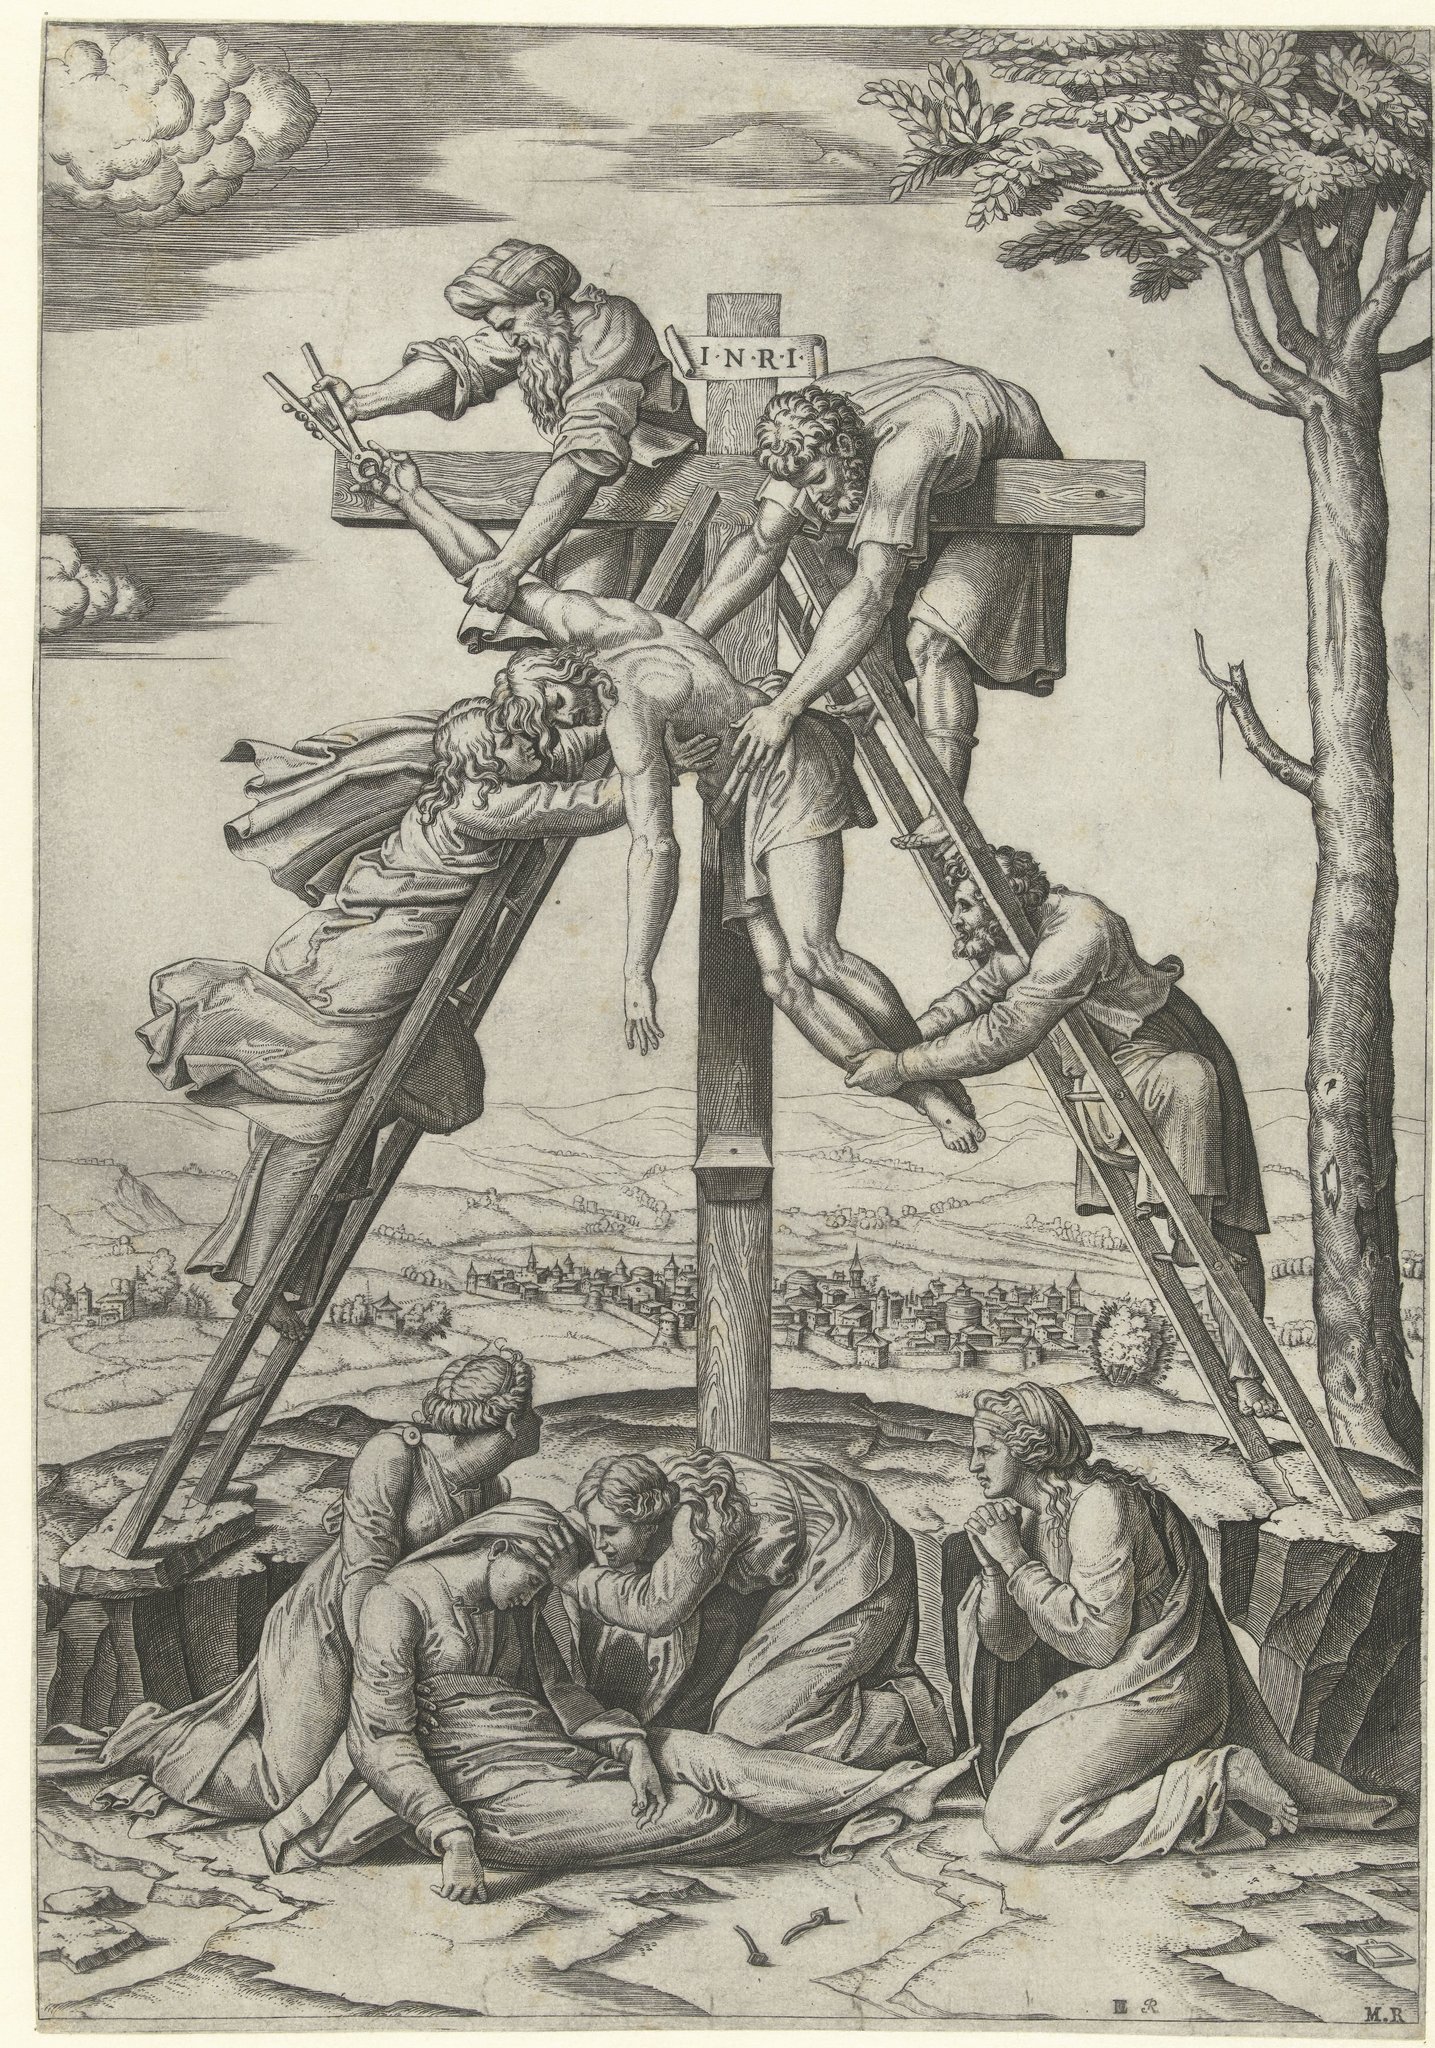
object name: print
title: Kruisafneming van Christus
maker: marcantonio raimondi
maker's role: print maker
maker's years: 1470-1534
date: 1520-1521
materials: paper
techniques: engraving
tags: descent from the cross: christ is taken down from the cross, usually by nicodemus and joseph of arimathaea who are standing on the ladders (both arms of christ detached)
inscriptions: collector's mark: Lugt 2228, collector's mark: Lugt 547, collector's mark: Lugt 2184, collector's mark: Lugt 1912, collector's mark: